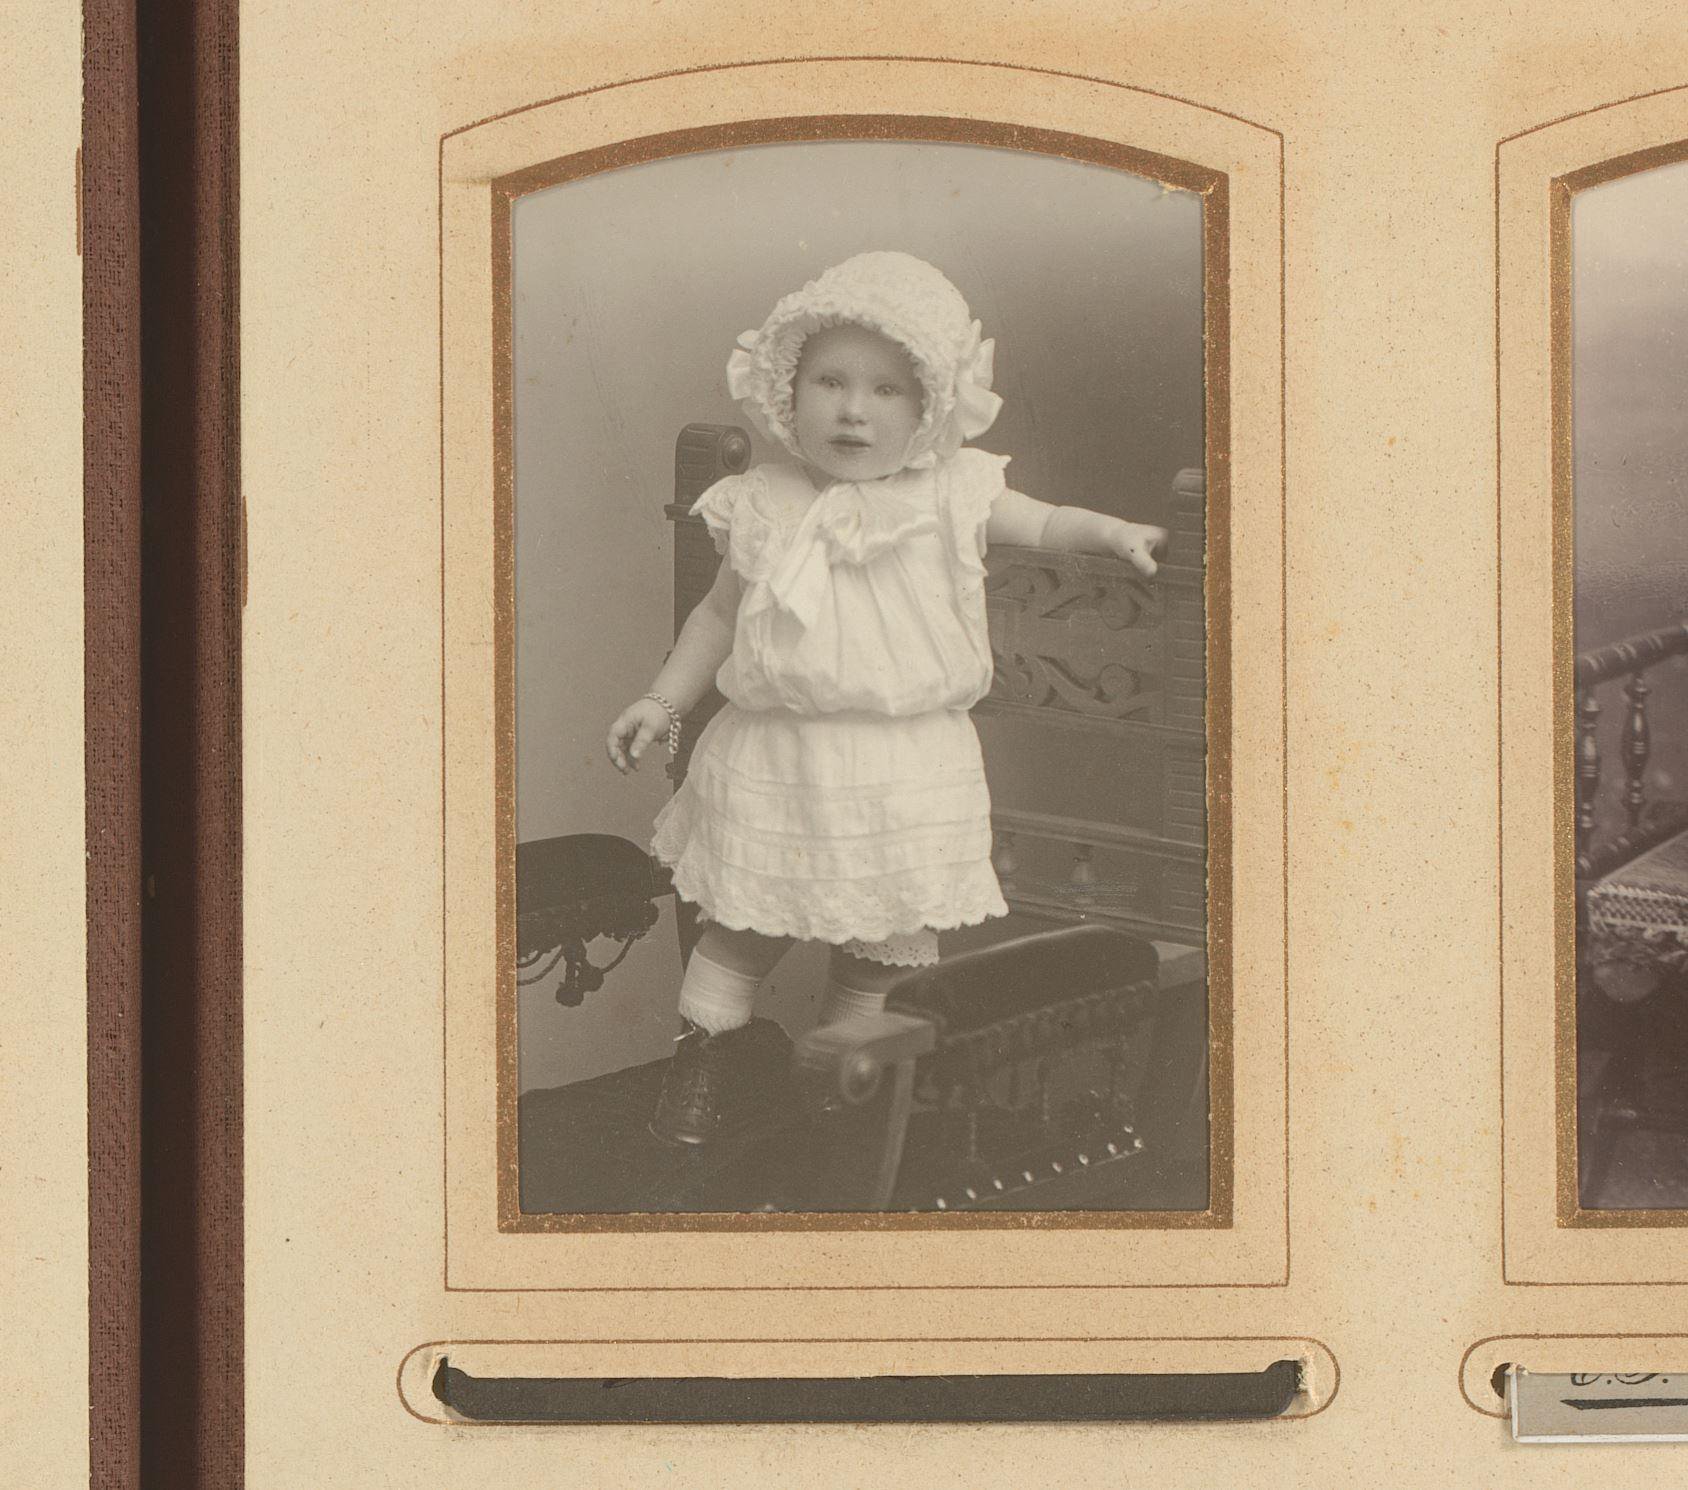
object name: carte de visite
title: Portret van een staand meisje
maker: Anonymous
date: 1890-1920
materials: cardboard, photographic support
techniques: collodion silver print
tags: girl (child between toddler and youth)